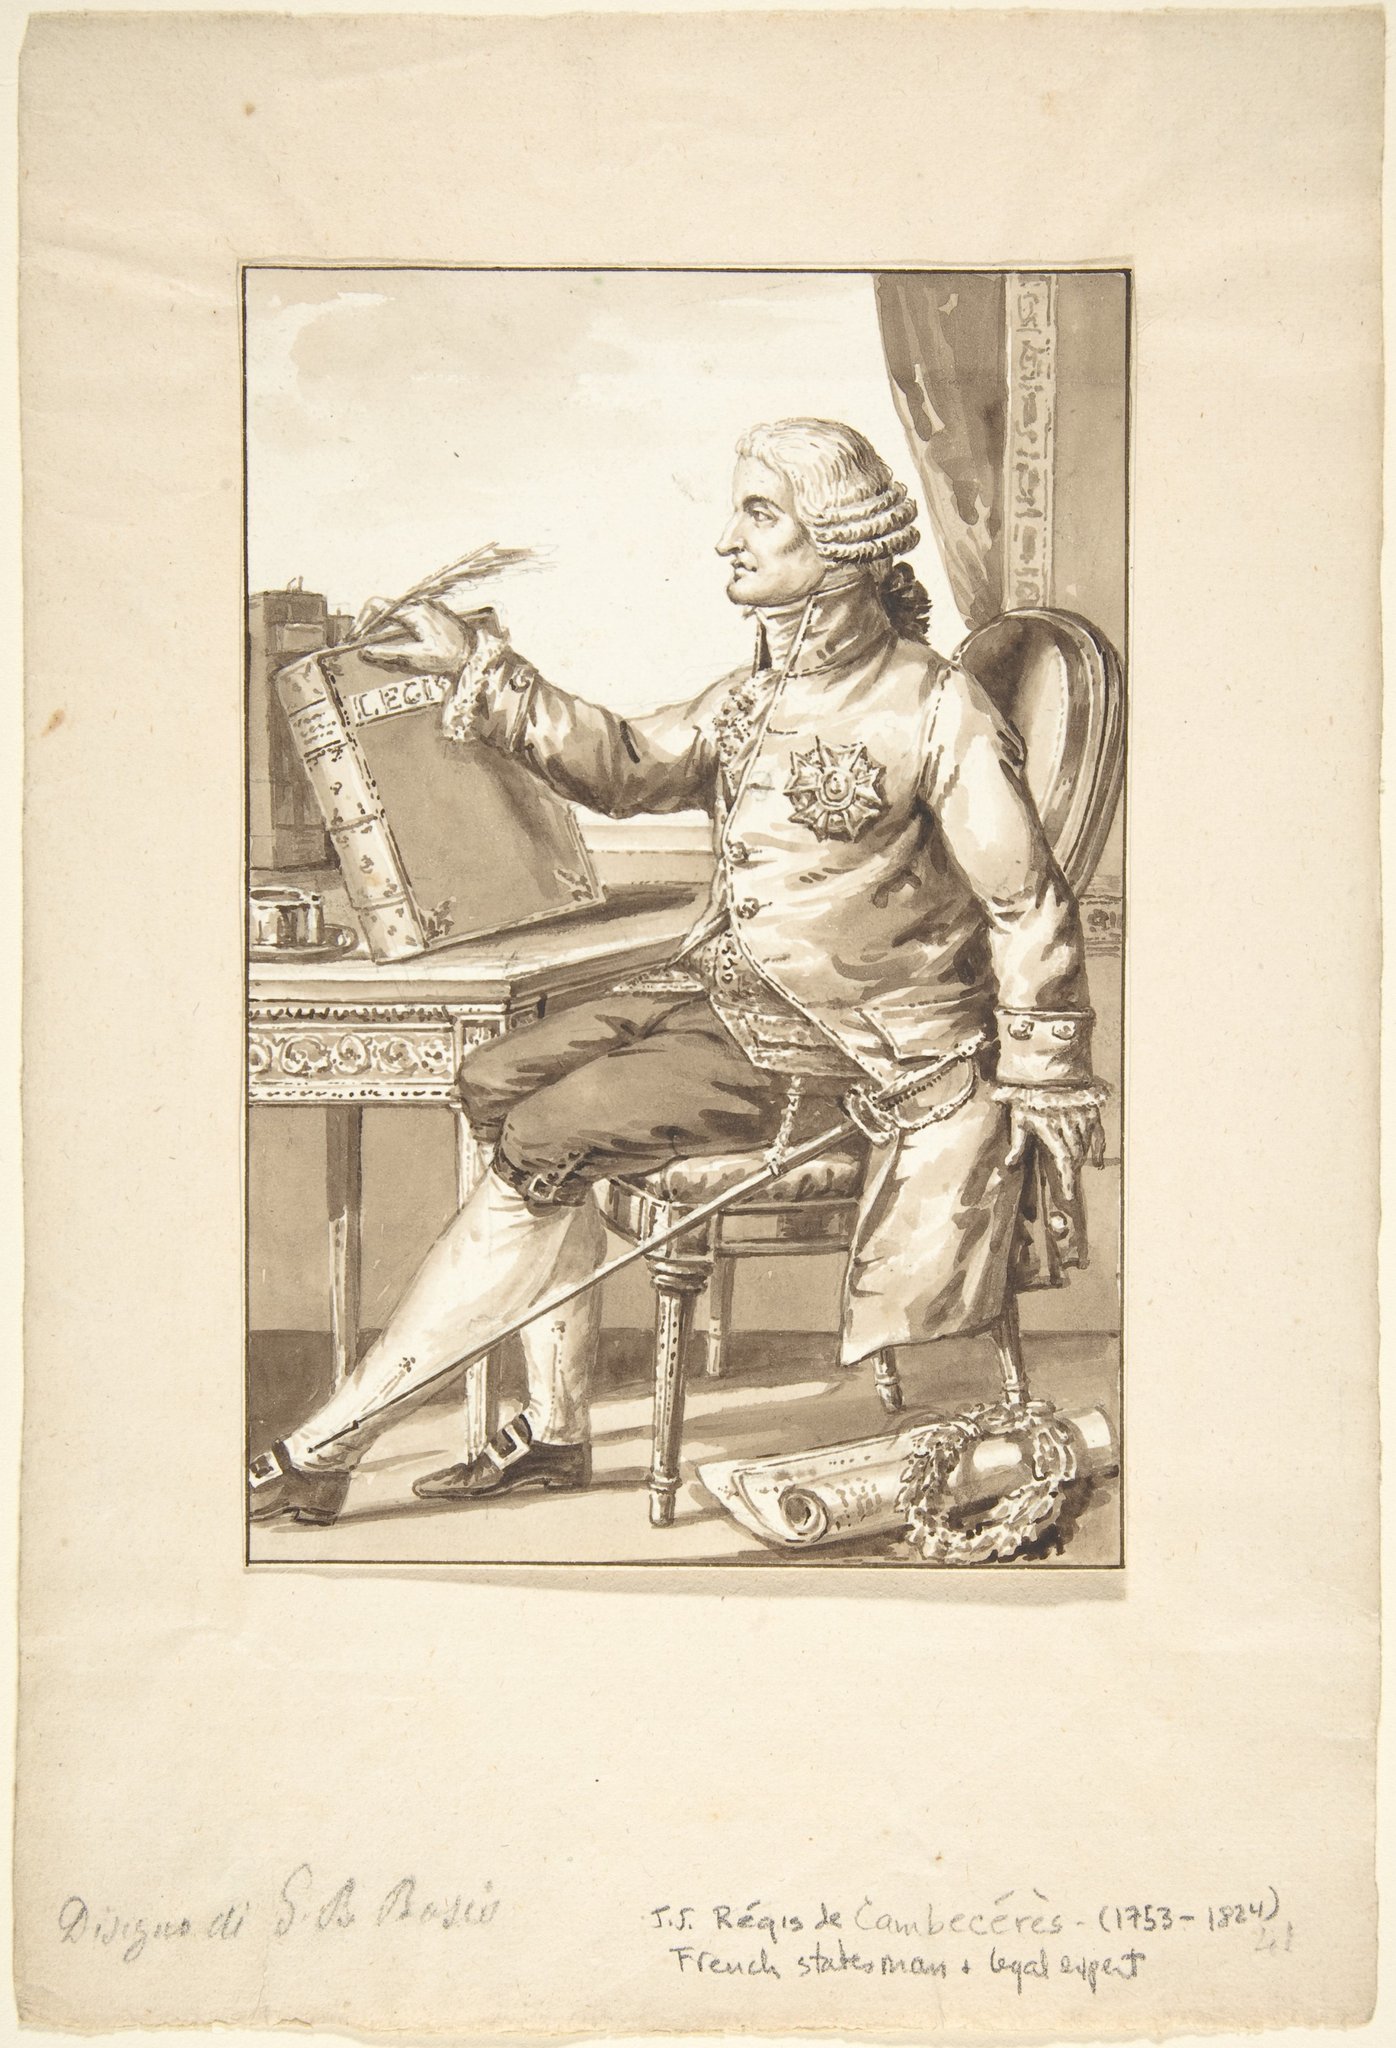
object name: drawing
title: Portrait of J. J. Régis de Cambecérès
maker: jean-baptiste-françois bosio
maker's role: artist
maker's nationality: french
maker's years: 1764-1827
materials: graphite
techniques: brush, wash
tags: men,portraits